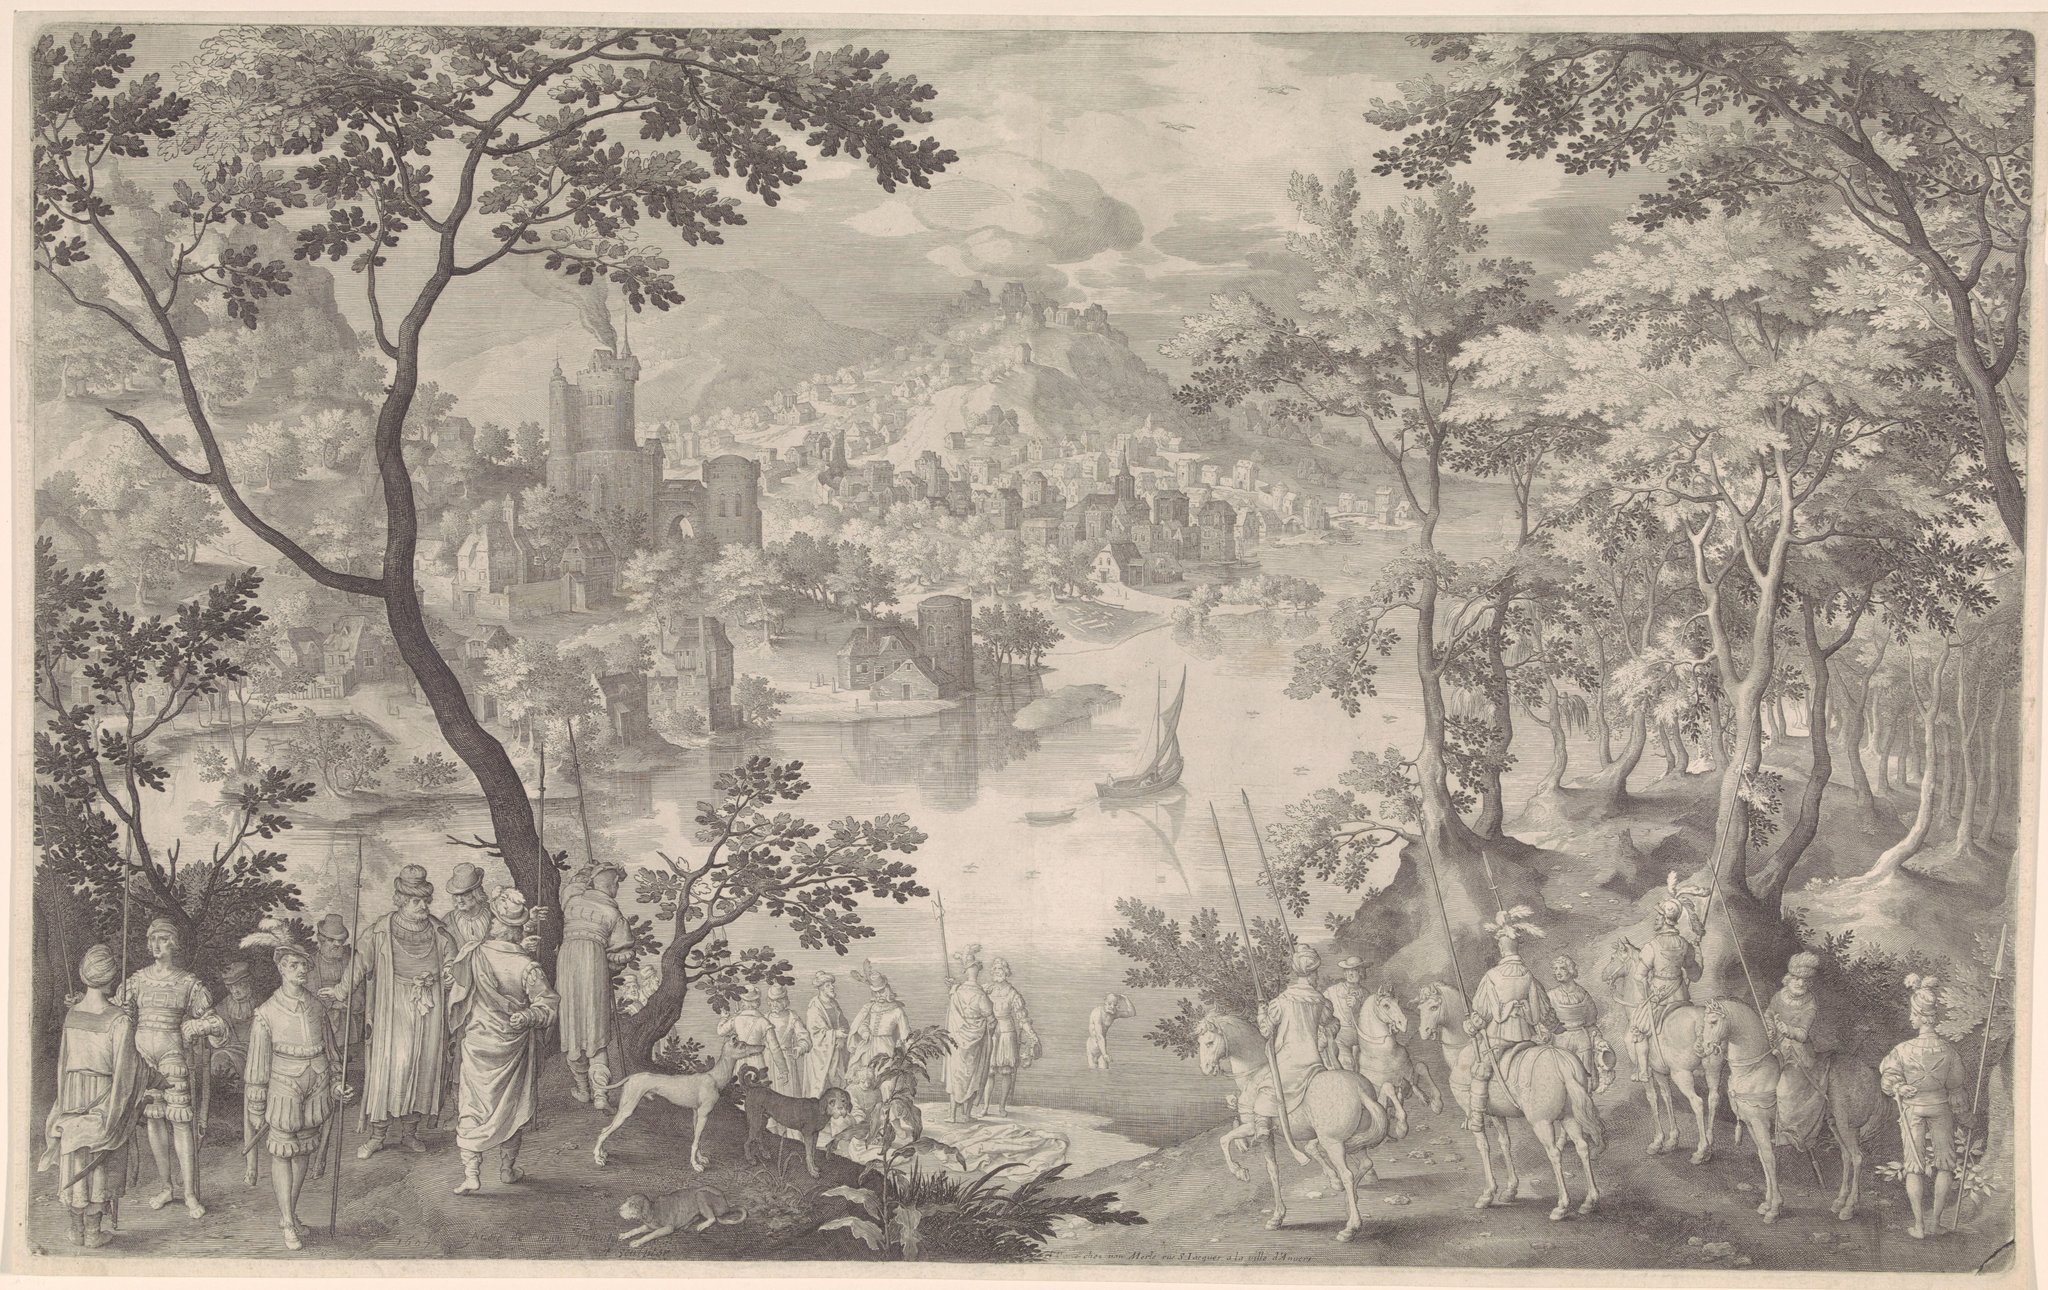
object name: print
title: Genezing van Naäman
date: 1607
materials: paper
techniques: engraving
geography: antwerp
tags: low hill country (+ landscape with figures, staffage), landscape with tower or castle, naaman comes to the jordan, dips himself seven times and is cured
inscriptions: collector's mark: Lugt 2228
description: Naäman baadt in de rivier de Jordaan. Op de oever soldaten uit zijn gevolg. Naäman was de bevelhebber van het Aramese leger en leed aan huidvraat. De profeet Elisa raadde hem aan in zevenmaal te baden in de Jordaan om te genezen van zijn ziekte.